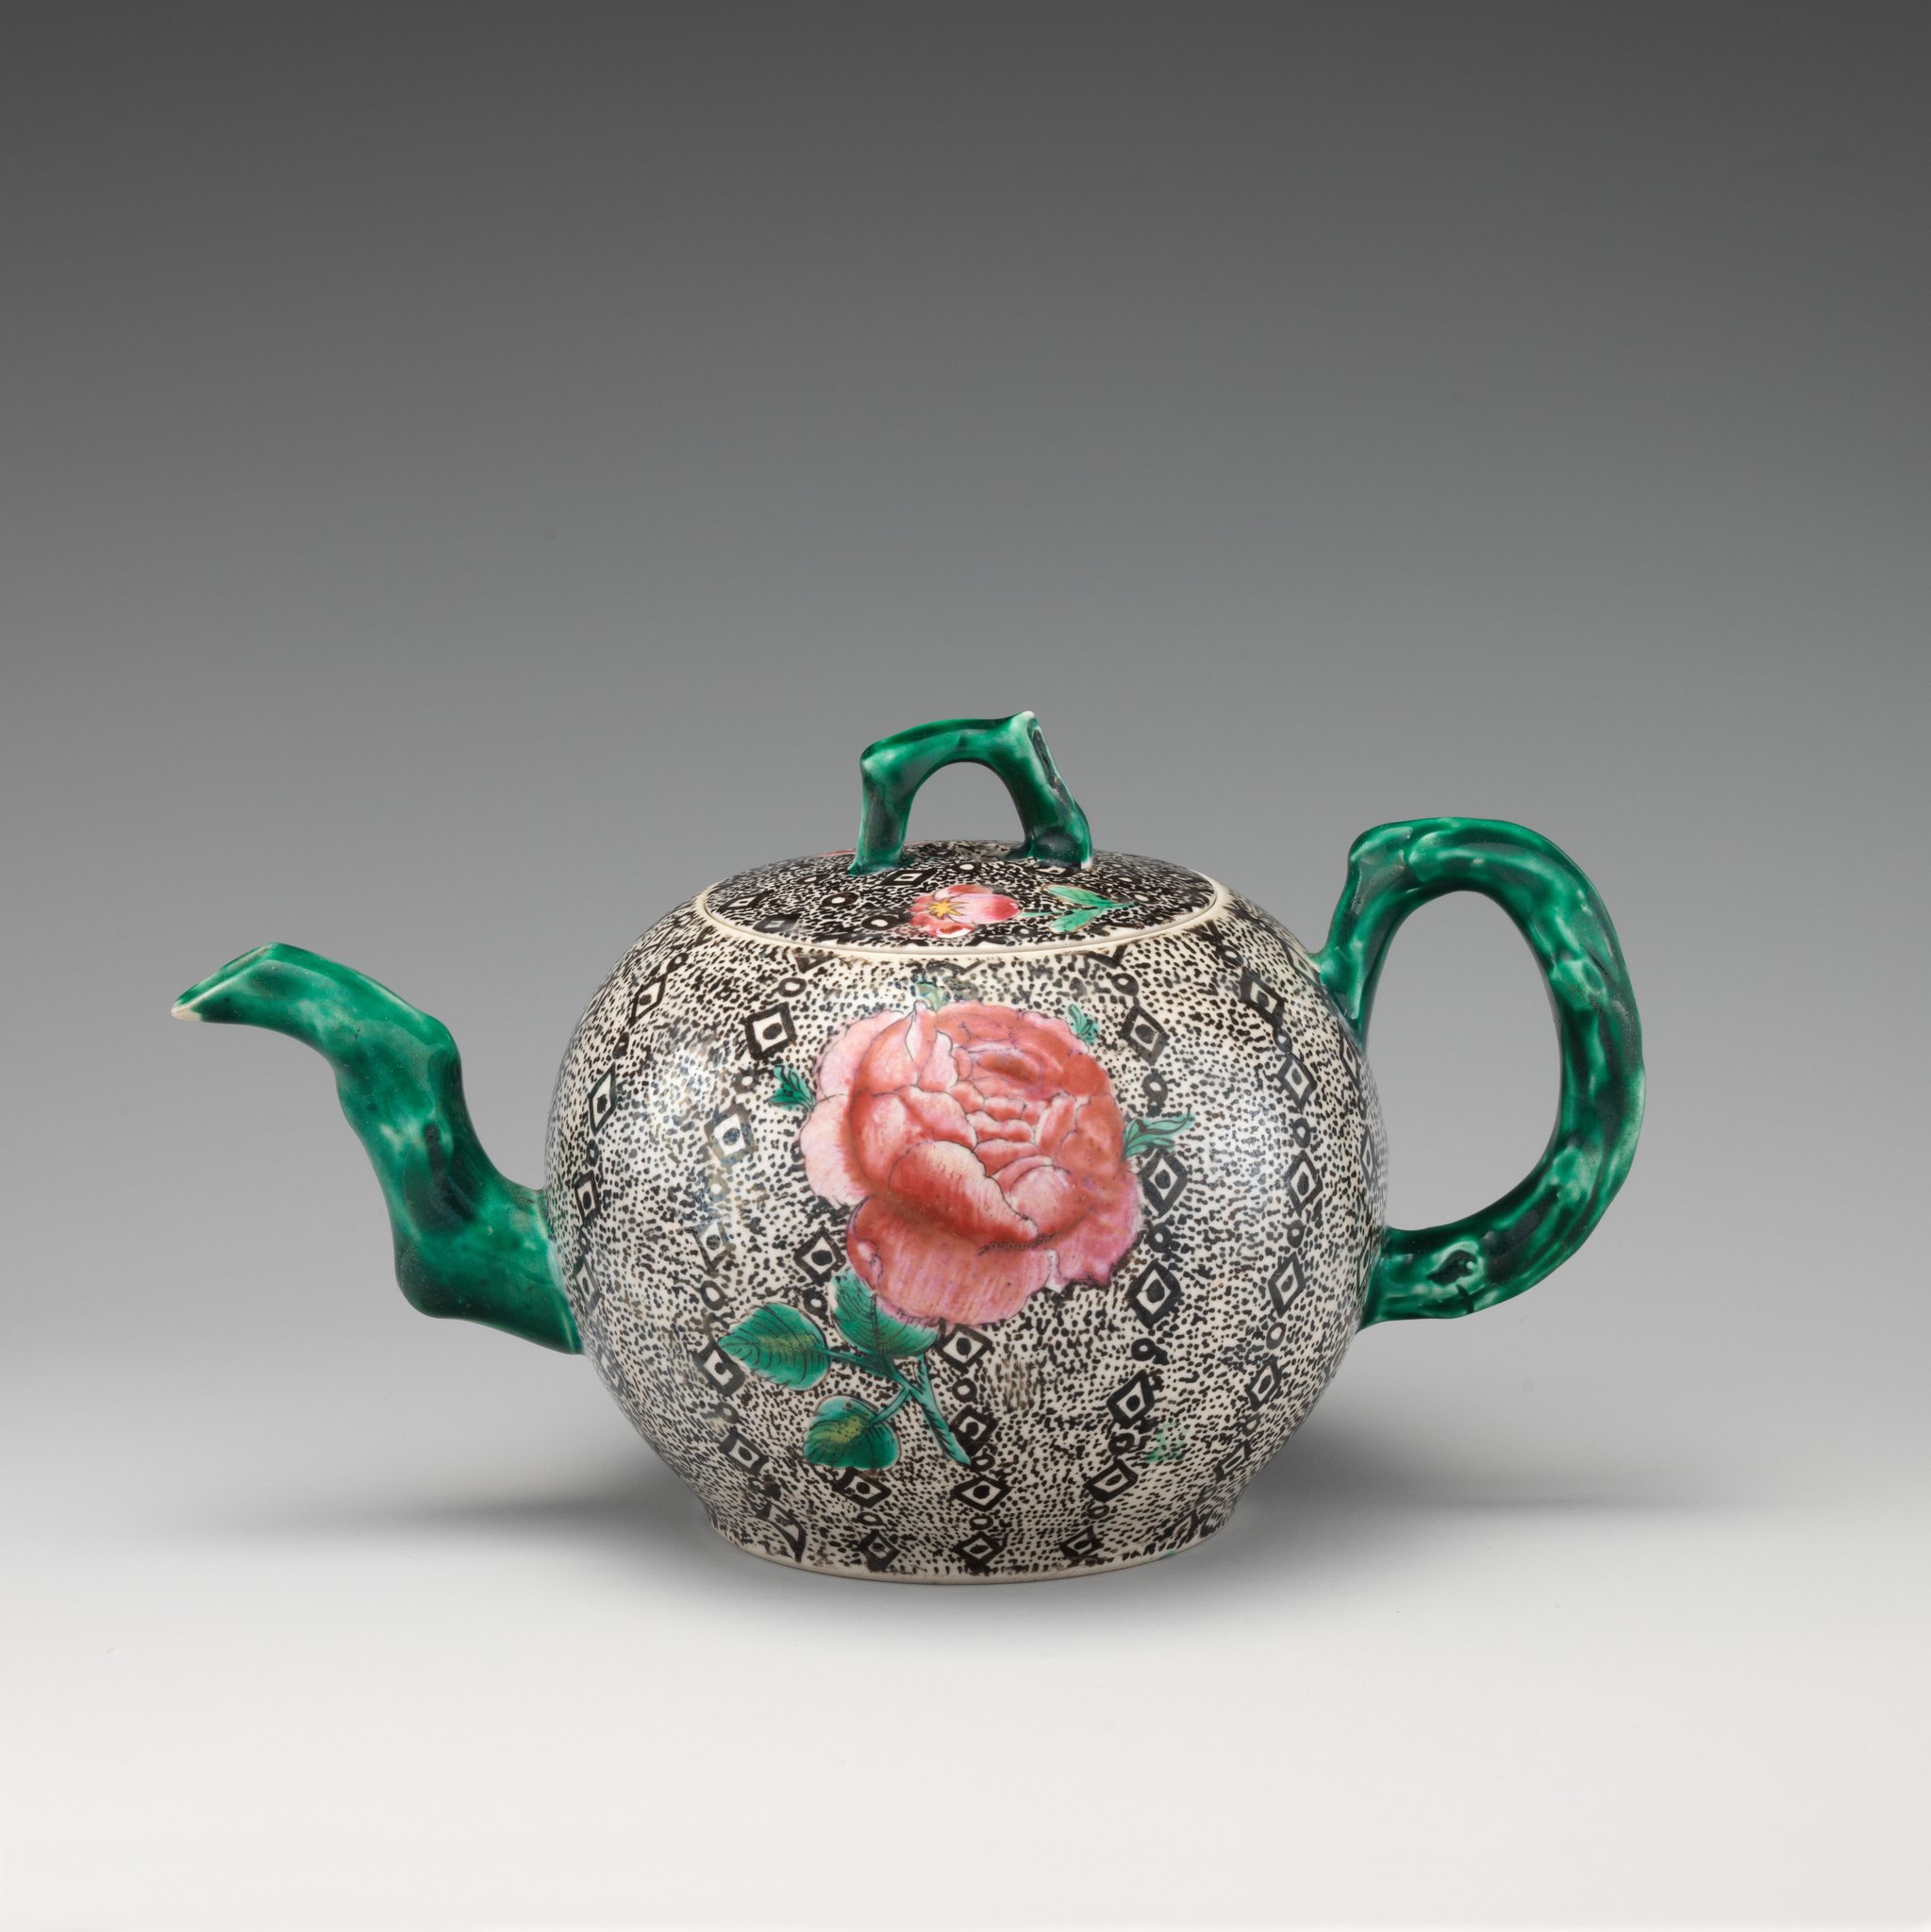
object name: teapot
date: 1765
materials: enamel, stoneware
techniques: salt glaze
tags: roses